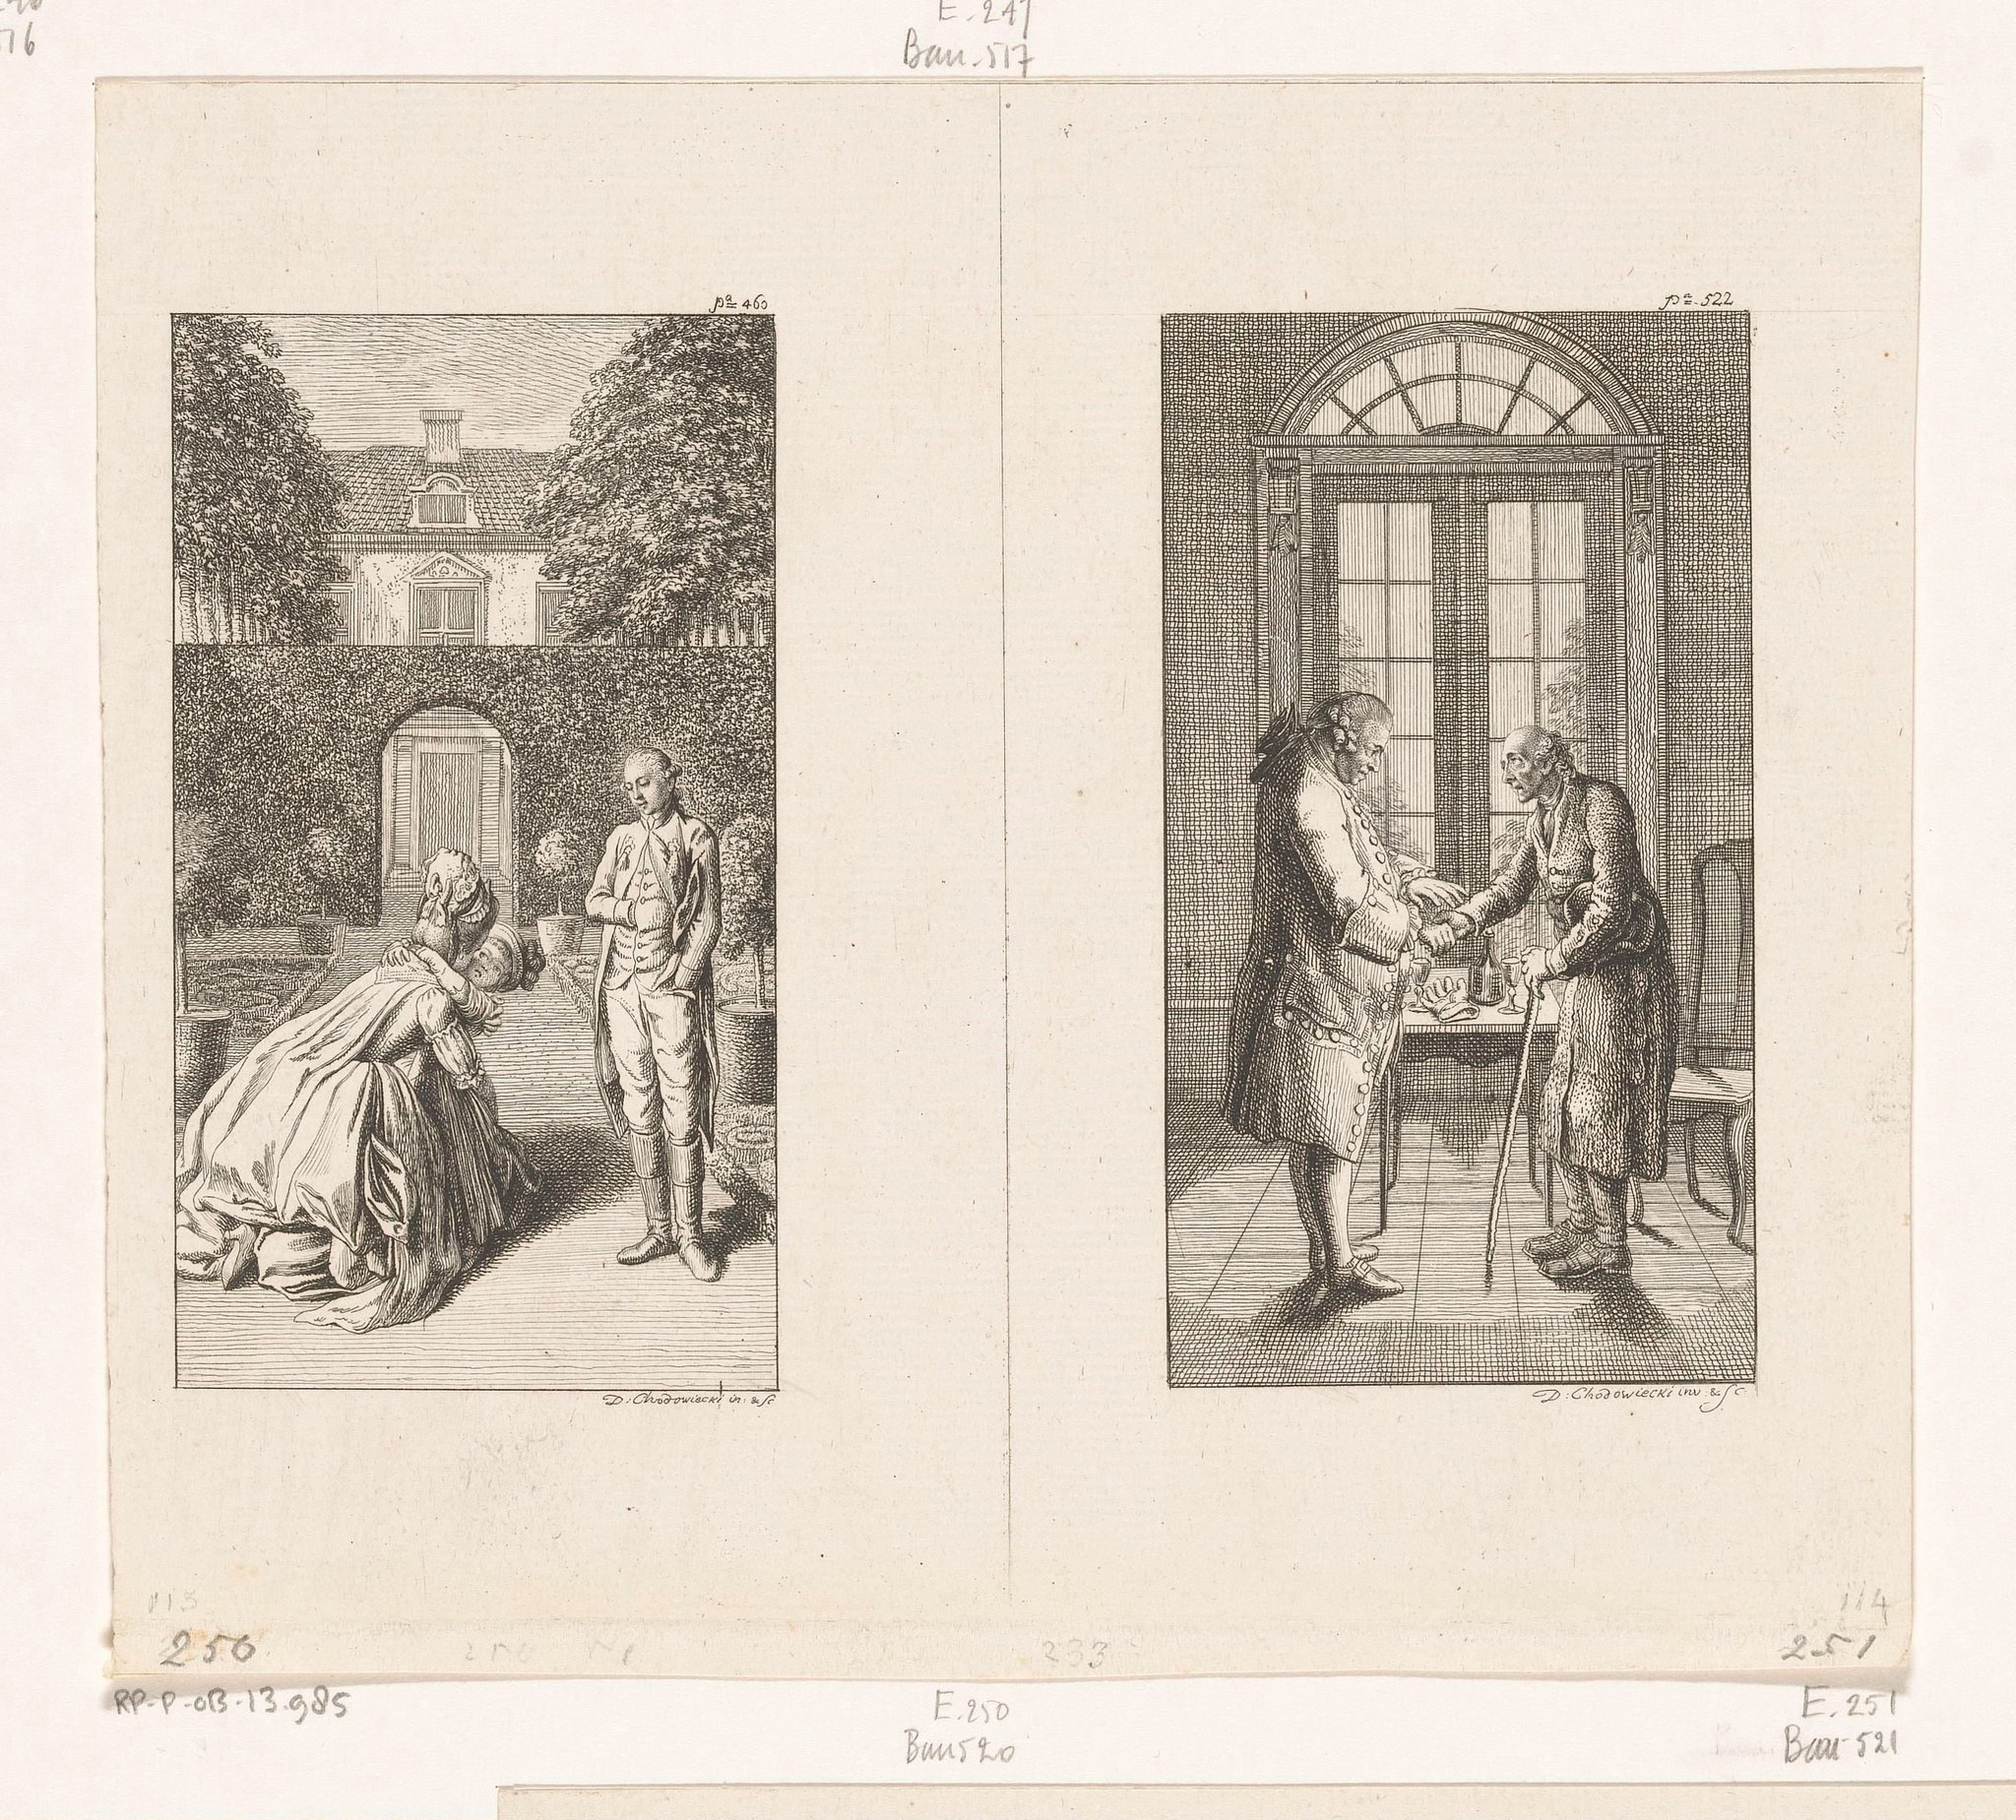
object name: print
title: Frau von Weesen met Alexander en Lorchen in de tuin en Herr von Geldern en de oude man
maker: daniel nikolaus chodowiecki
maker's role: draughtsman, print maker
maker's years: 1726-1801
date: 1778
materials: paper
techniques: etching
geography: berlin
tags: shaking hands, 'dextrarum junctio', literature, gloves, mittens, etc., garden, embracing each other, kissing, old man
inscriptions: collector's mark: Lugt 2228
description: Links omhelst Frau von Weesen haar dochter Lorchen in de tuin van haar broer, Herr von Geldern. Naast haar staat Alexander. Rechts schudt Herr von Geldern een oude man de hand die nog maar enkele dagen te leven heeft. Hij heeft hem een paar handschoenen cadeau gedaan, maar de oude man gebruikt alleen de linker handschoen, de rechter ligt op tafel.